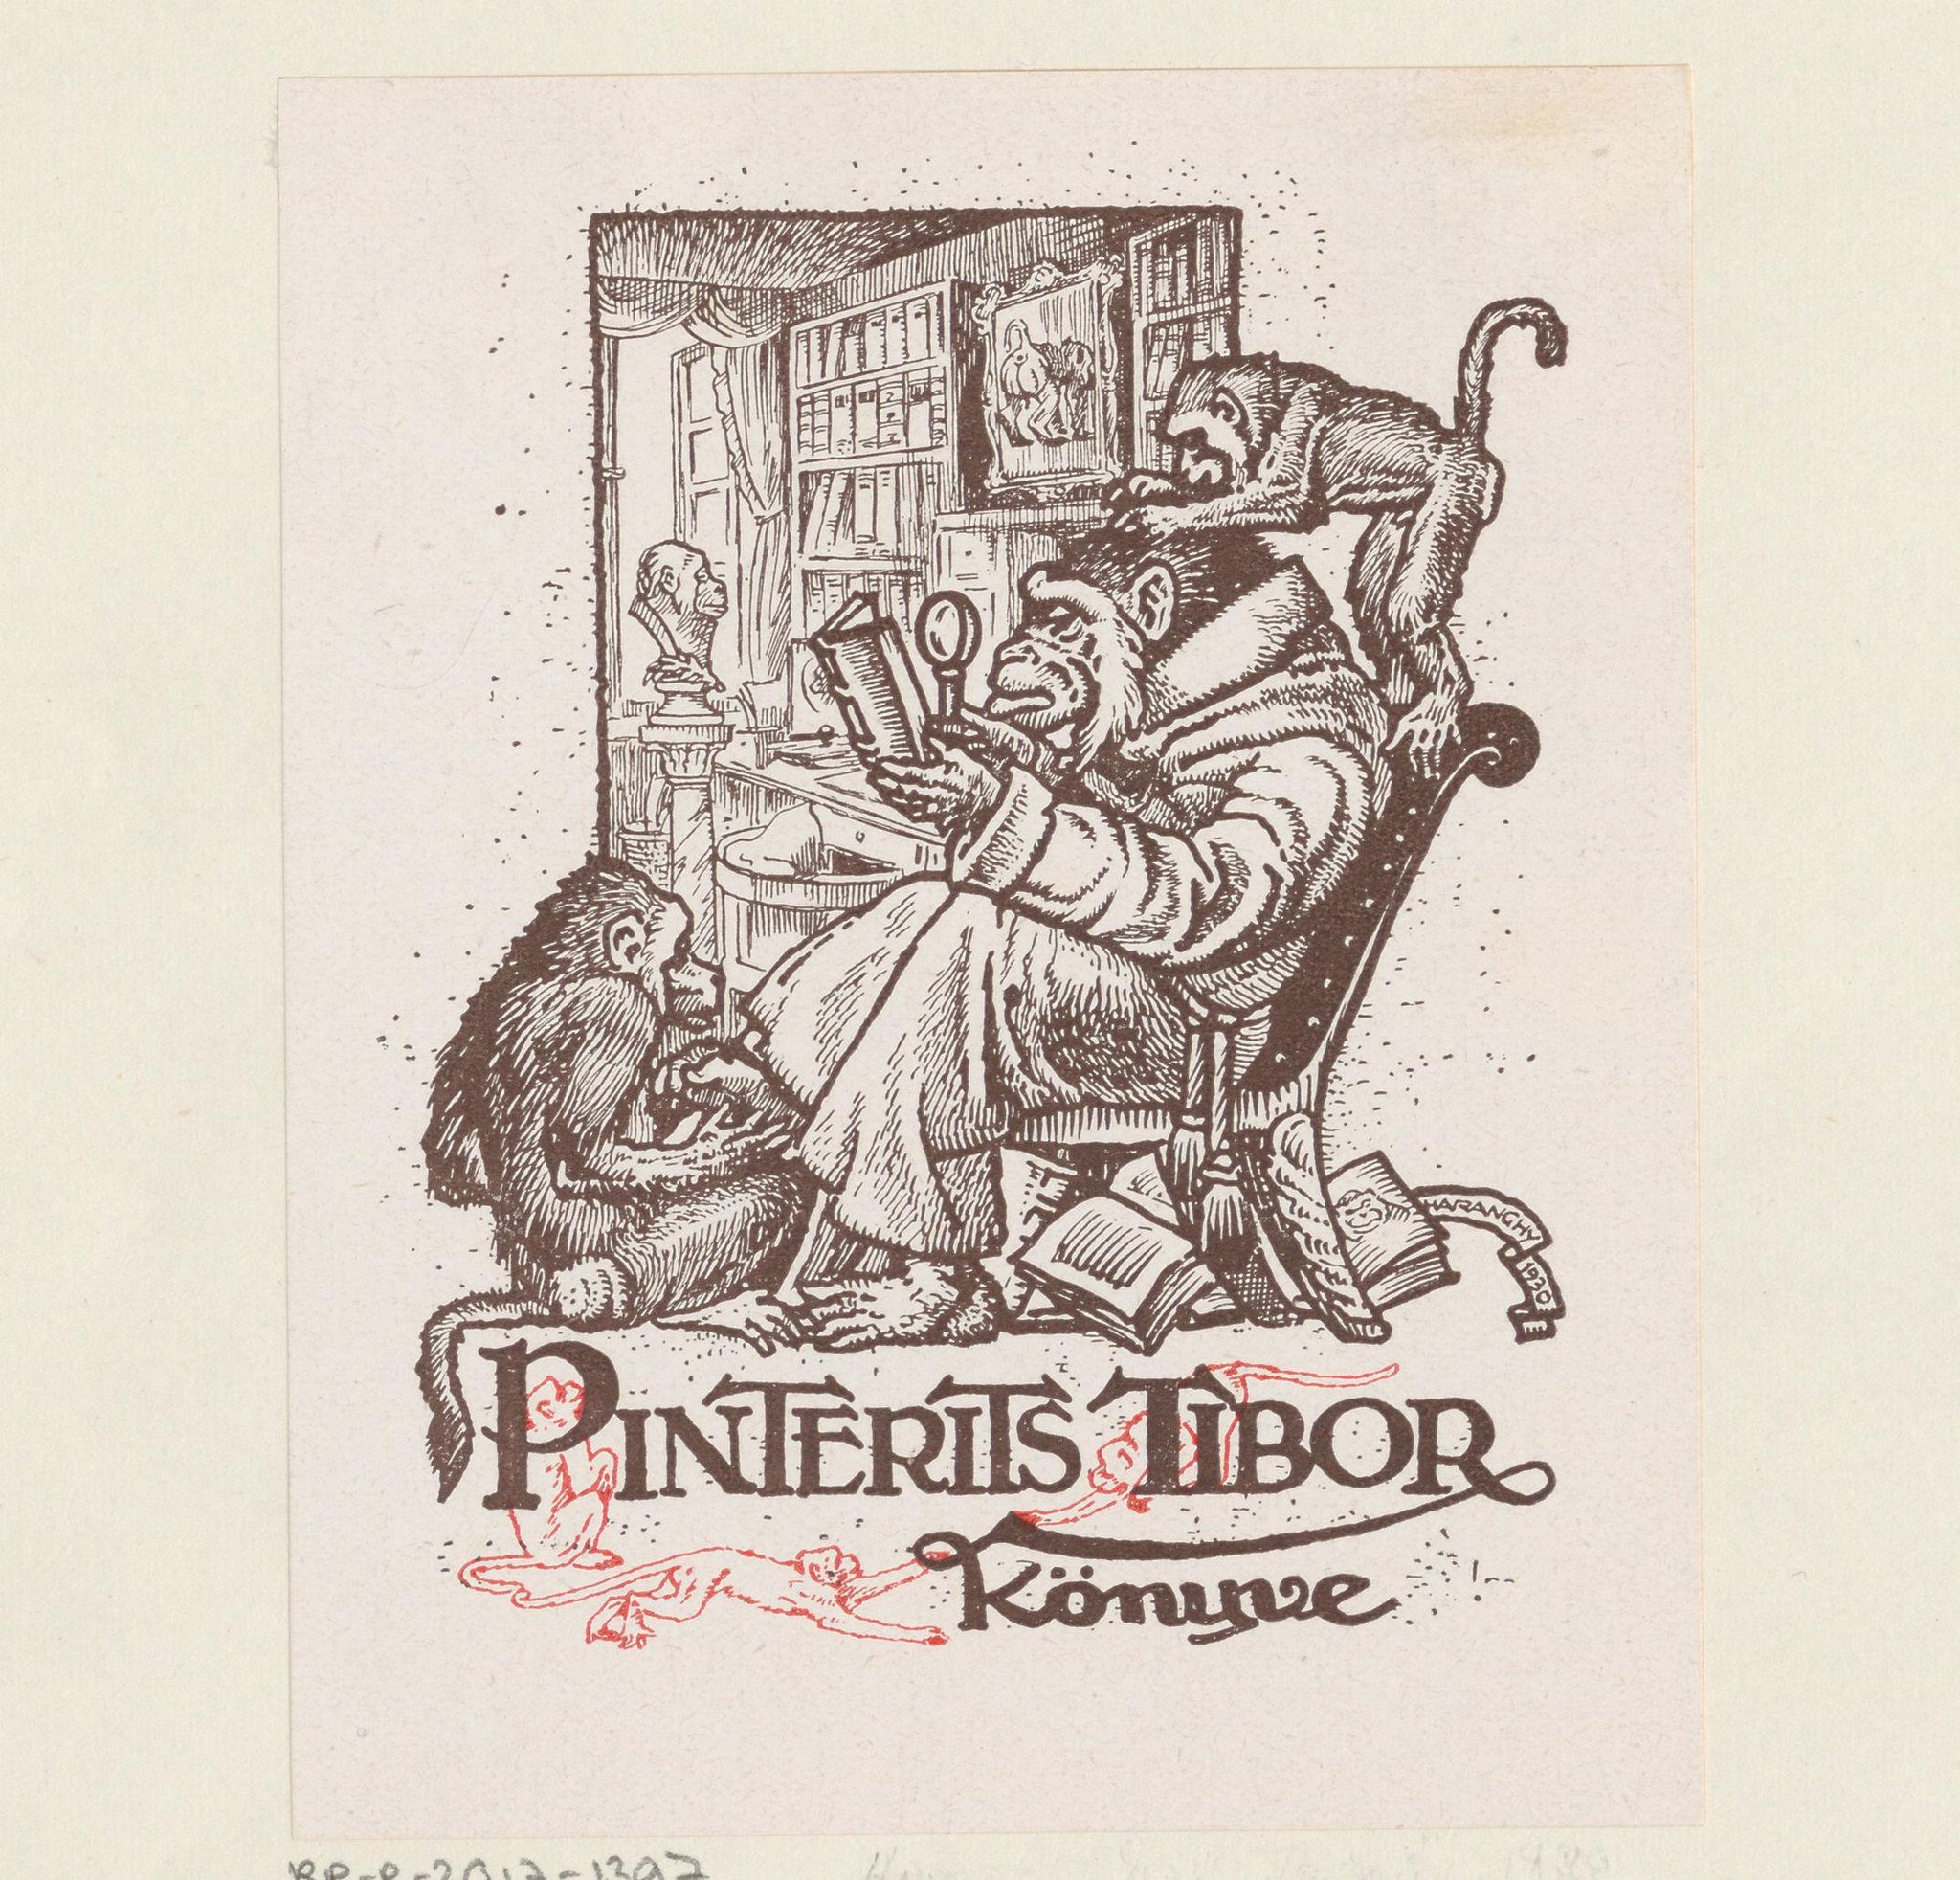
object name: bookplate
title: Ex libris van Tibor Pinterits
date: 1930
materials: paper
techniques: printing block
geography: hungary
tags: reading, monkeys, apes, study; 'studiolo'; library, looking for fleas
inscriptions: date